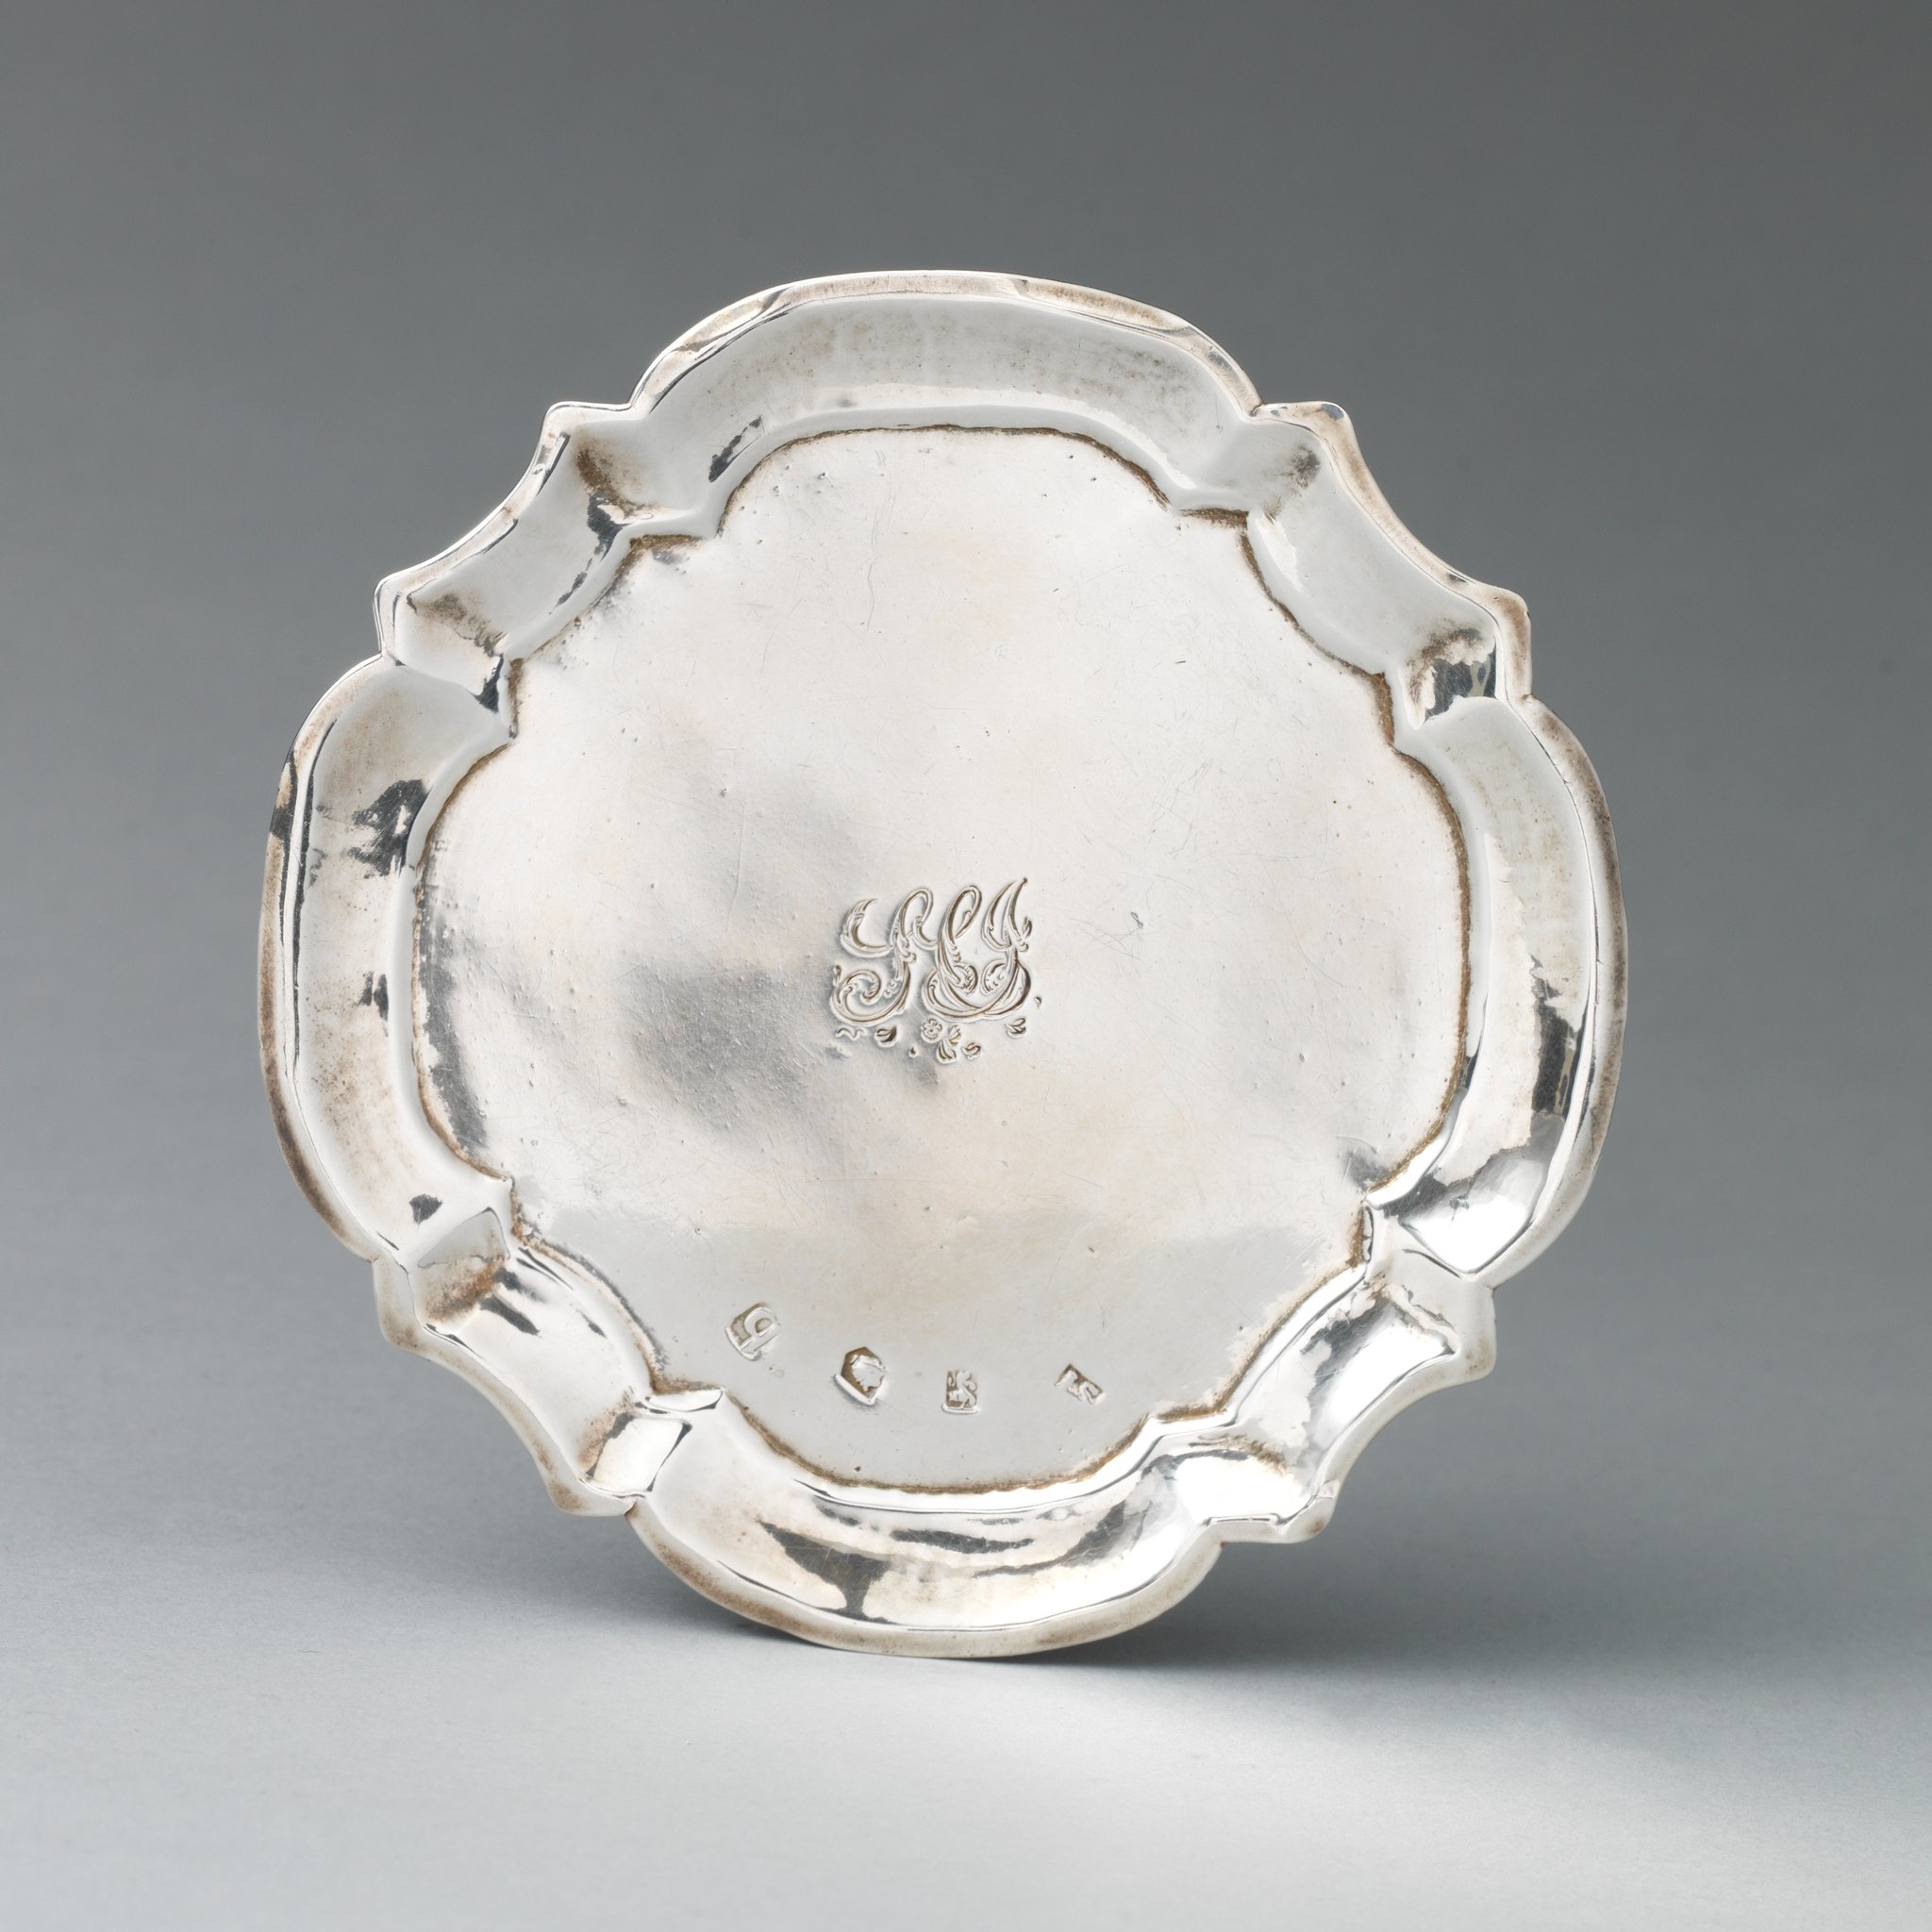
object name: waiter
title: Miniature waiter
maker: is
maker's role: maker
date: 1737-1738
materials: silver